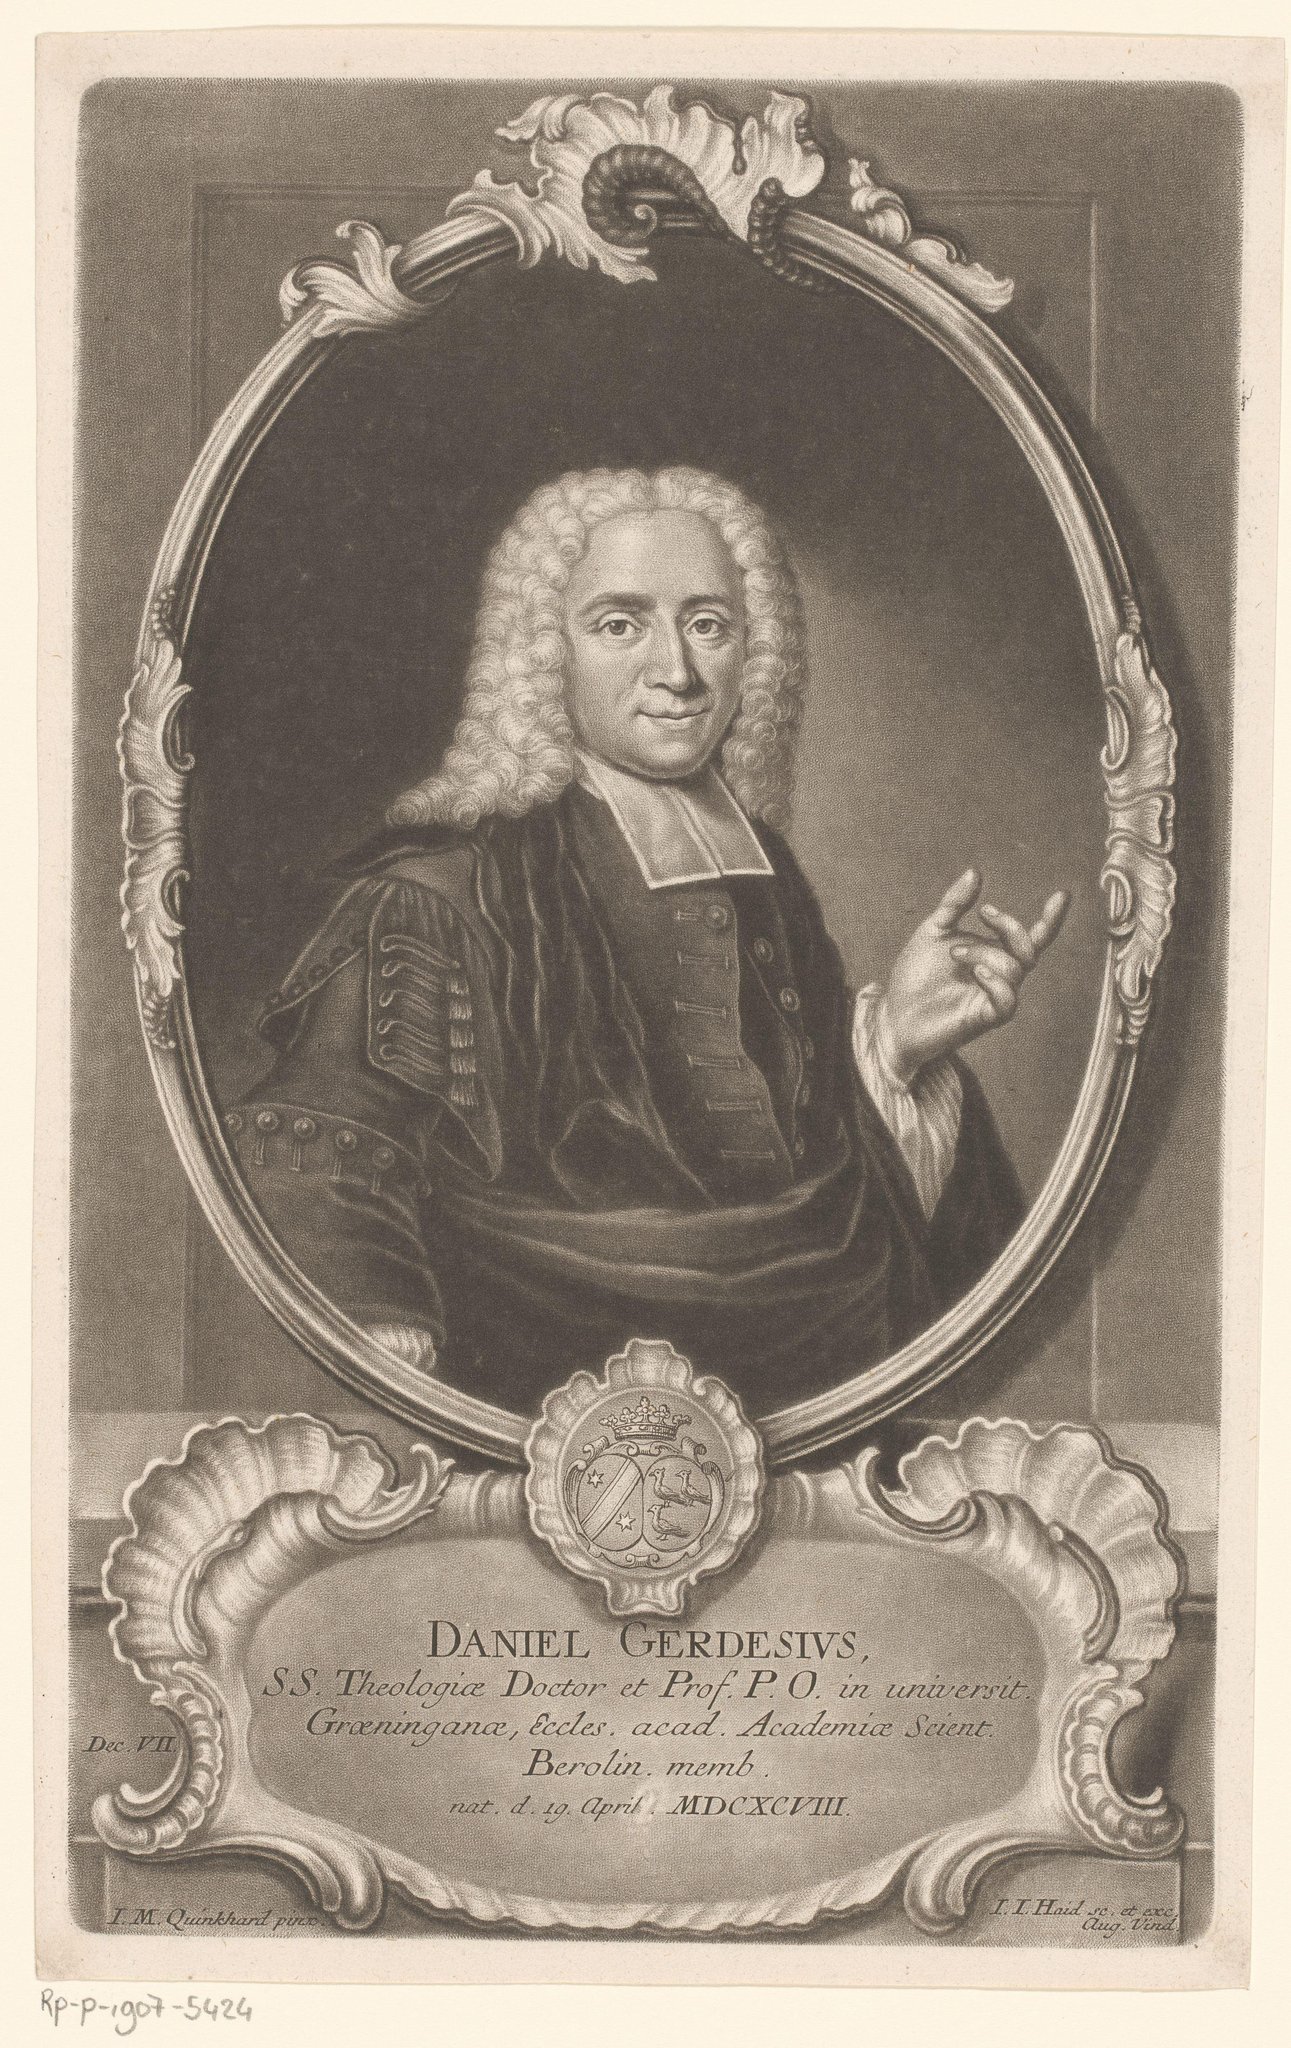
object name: print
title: Portret van Daniël Gerdes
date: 1748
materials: paper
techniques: etching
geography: augsburg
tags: rocaille ornament, theologian, historical persons, armorial bearing, heraldry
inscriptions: collector's mark: Lugt 2228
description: Prent gebruikt voor: Brucker, Jacob. Bildersal heutiges Tages lebender und durch Gelahrtheit berühmter Schrifftsteller. Augsburg: Johann Jacob Haid, 1748.